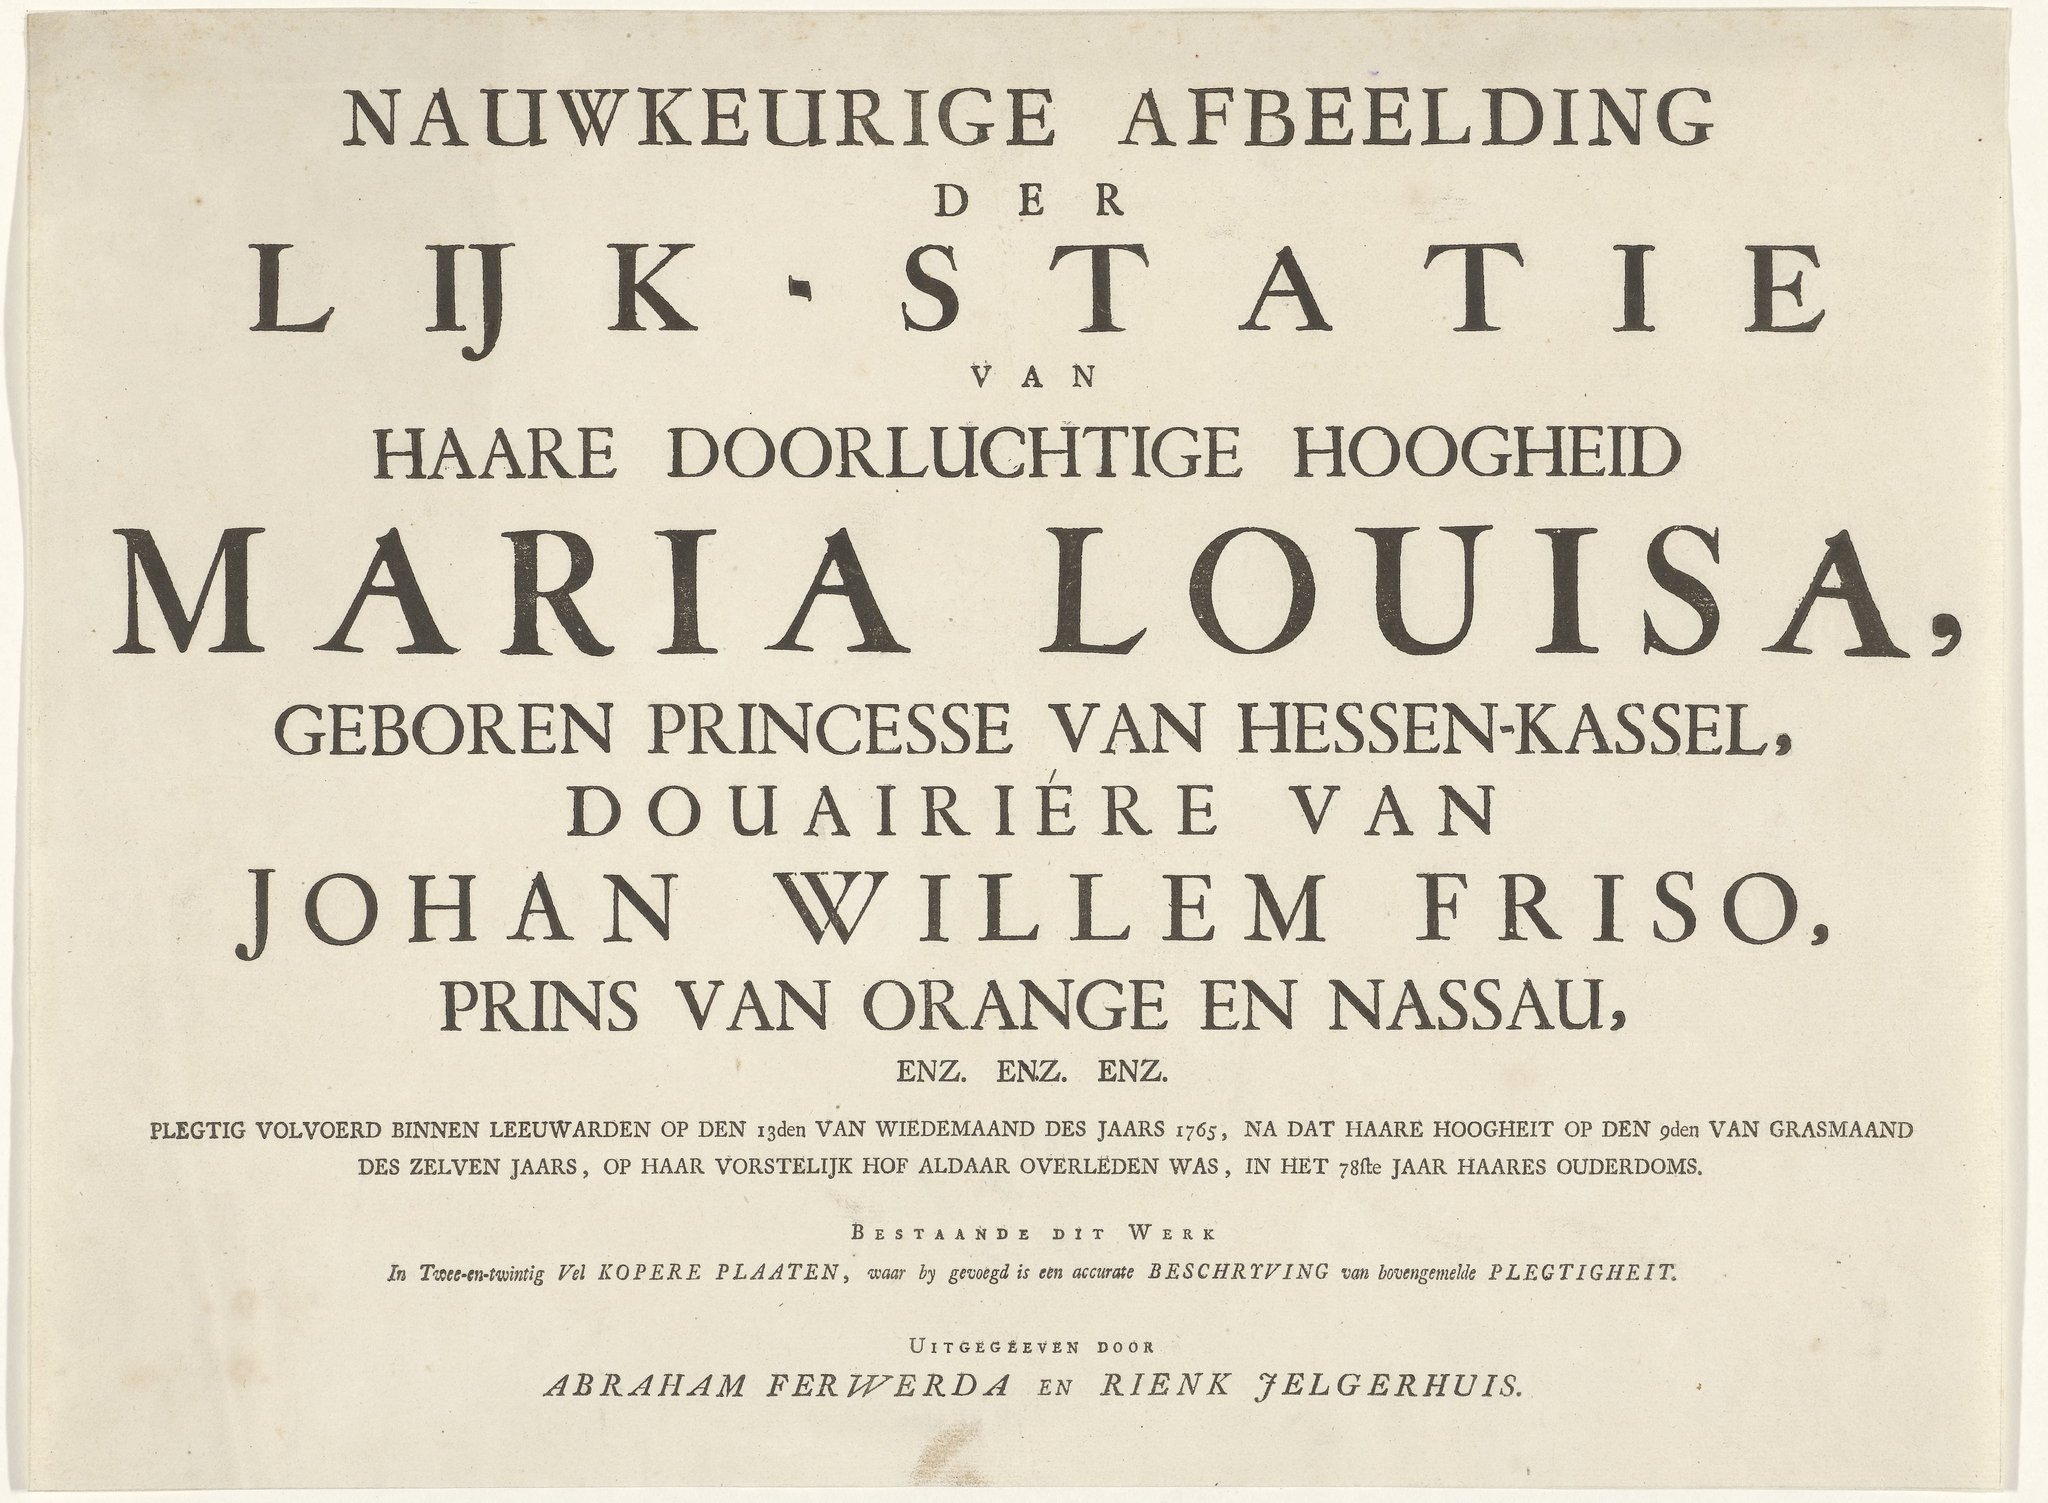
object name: titelblad, titelpagina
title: Nauwkeurige Afbeelding der Lijk-statie van Haare Doorluchtige Hoogheid Maria Louisa, (...) Plegtig volvoerd binnen Leeuwarden op den 13den van Wiedemaand des jaars 1765 (...)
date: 1765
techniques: letterpress printing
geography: leeuwarden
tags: kassel, leeuwarden, maria louisa van hessen-kassel, begrafenis van maria louise, prinses van oranje-nassau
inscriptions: date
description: Titelblad voor de serie van 21 platen van de begrafenis van prinses Maria Louise te Leeuwarden op 13 juni 1765.